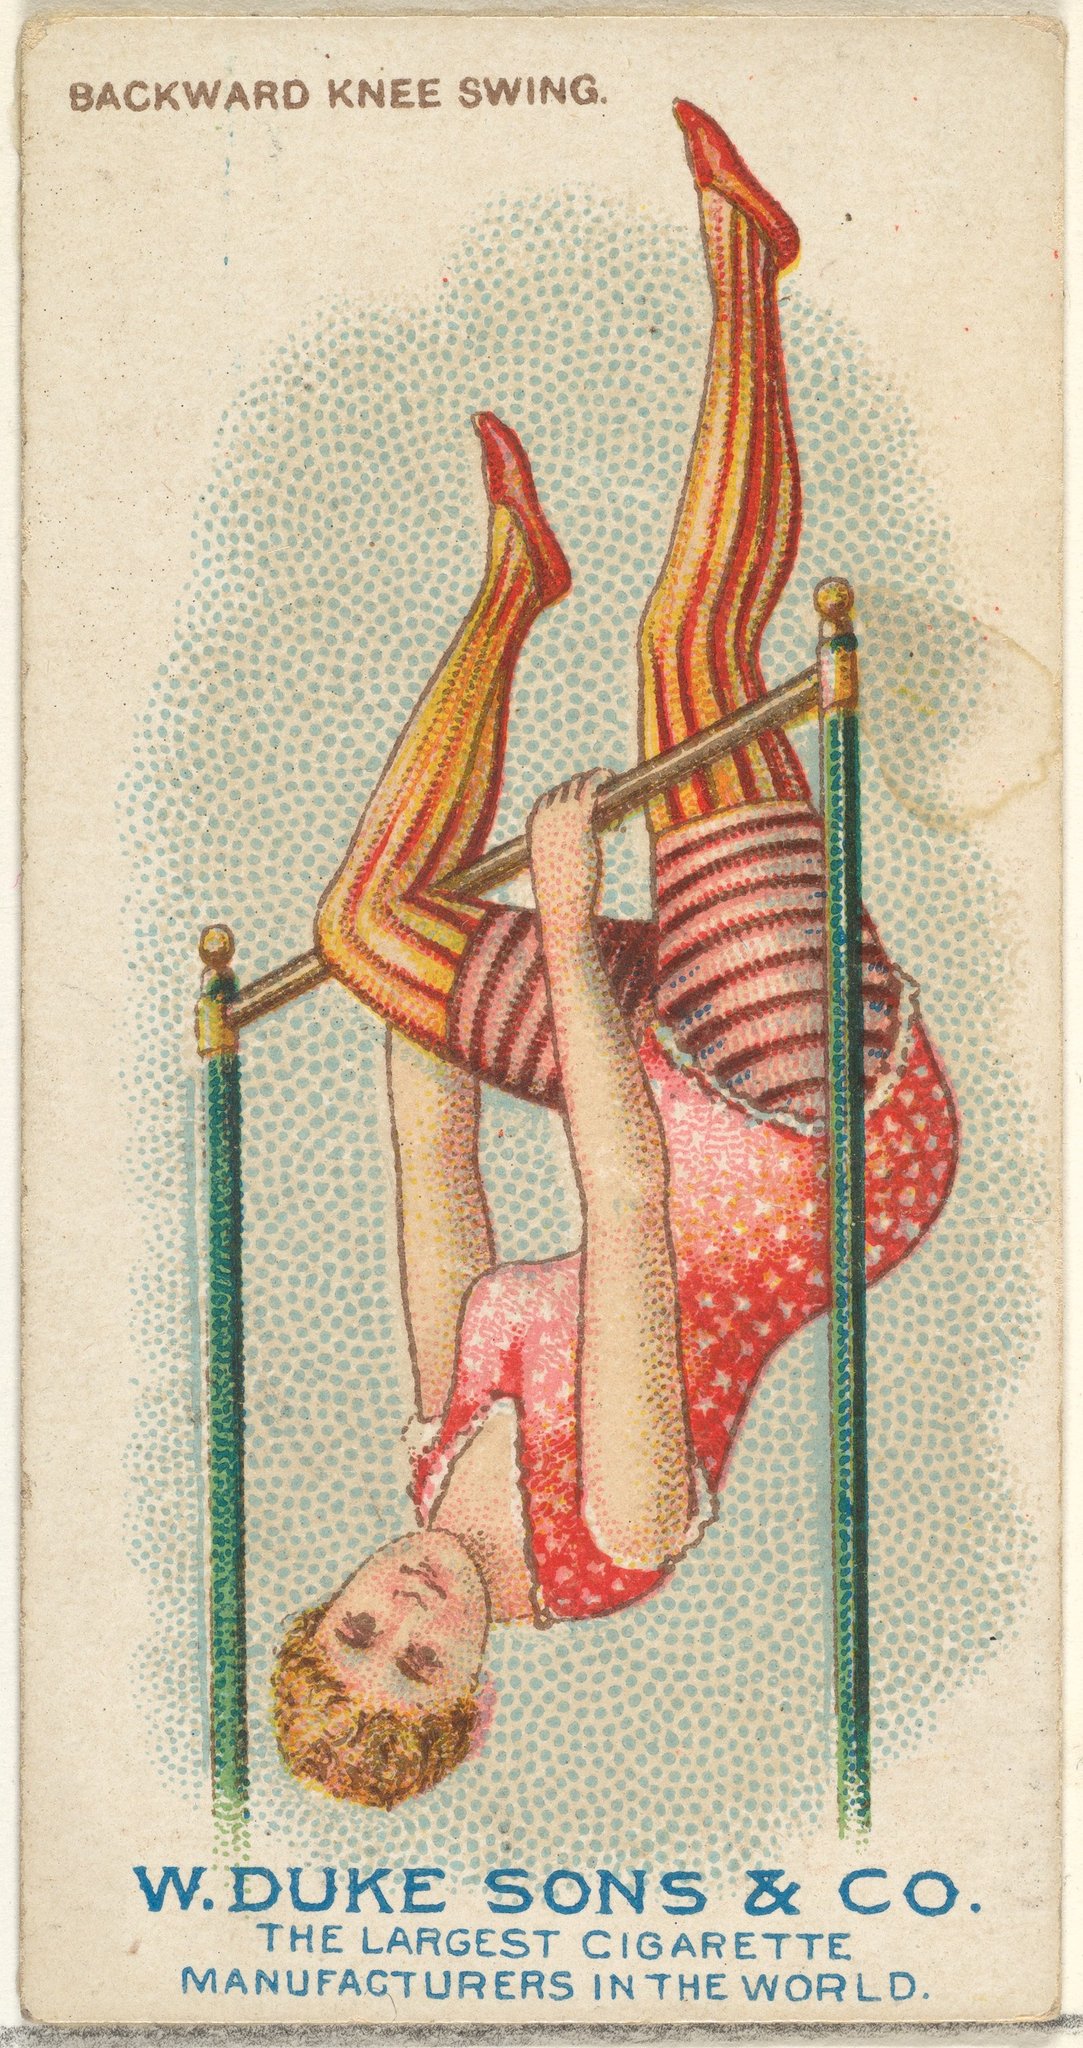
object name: print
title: Backward Knee Swing, from the Gymnastic Exercises series (N77) for Duke brand cigarettes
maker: w. duke, sons & co.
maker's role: publisher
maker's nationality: american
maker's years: 1870-1920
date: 1887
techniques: color lithograph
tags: women,athletes